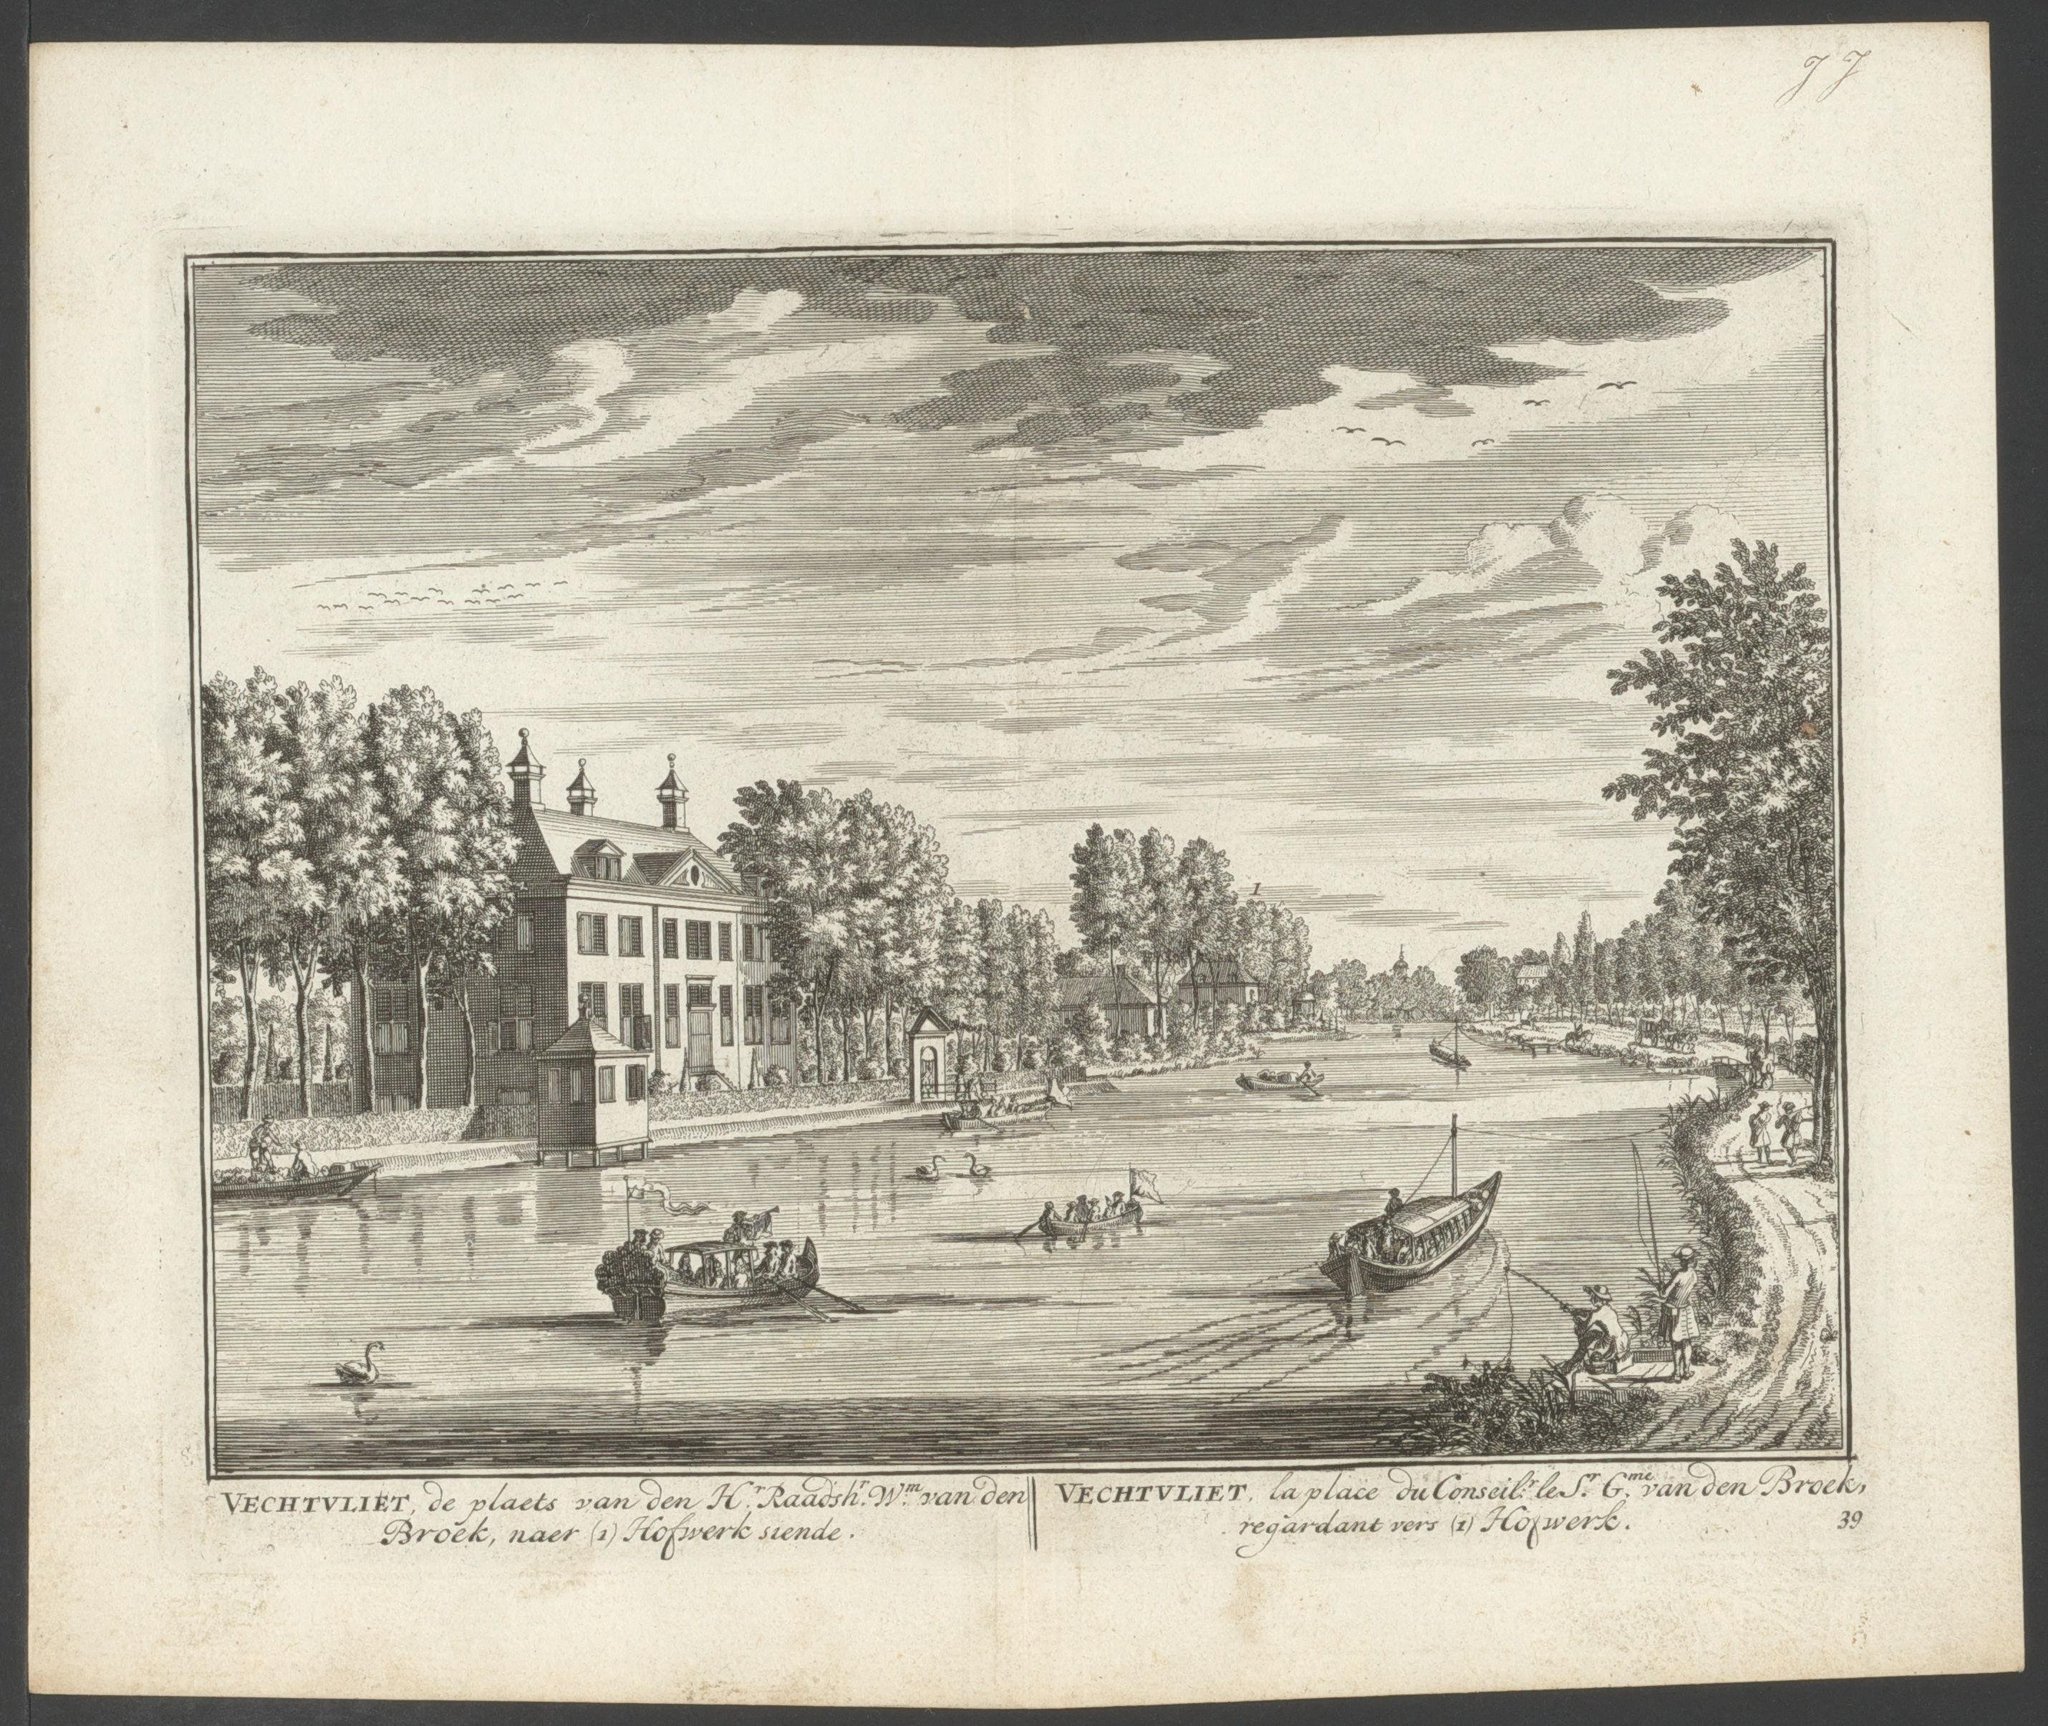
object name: print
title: Gezicht op de buitenplaats Vegtvliet aan de Vecht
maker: daniël stopendaal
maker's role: print maker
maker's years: 1672-1726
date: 1790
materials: paper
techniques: engraving, etching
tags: river (+ landscape with figures, staffage), country-house, vecht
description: Prent mogelijk uit: Leth, Andries de. De zegepraalende Vecht, vertoonende verscheidene gesichten van lustplaatsen, heeren huysen en dorpen, beginnende van Uitrecht en met Muyden besluytende (...). Amsterdam: Weduwe Nicolaus Visscher, 1719. Of uit: Brouërius van Nidek, Matthaeus. De Vechtstroom, van Utrecht tot Muiden (...). Amsterdam: H. Gartman, W. Vermandel en J.W. Smit, 1790.